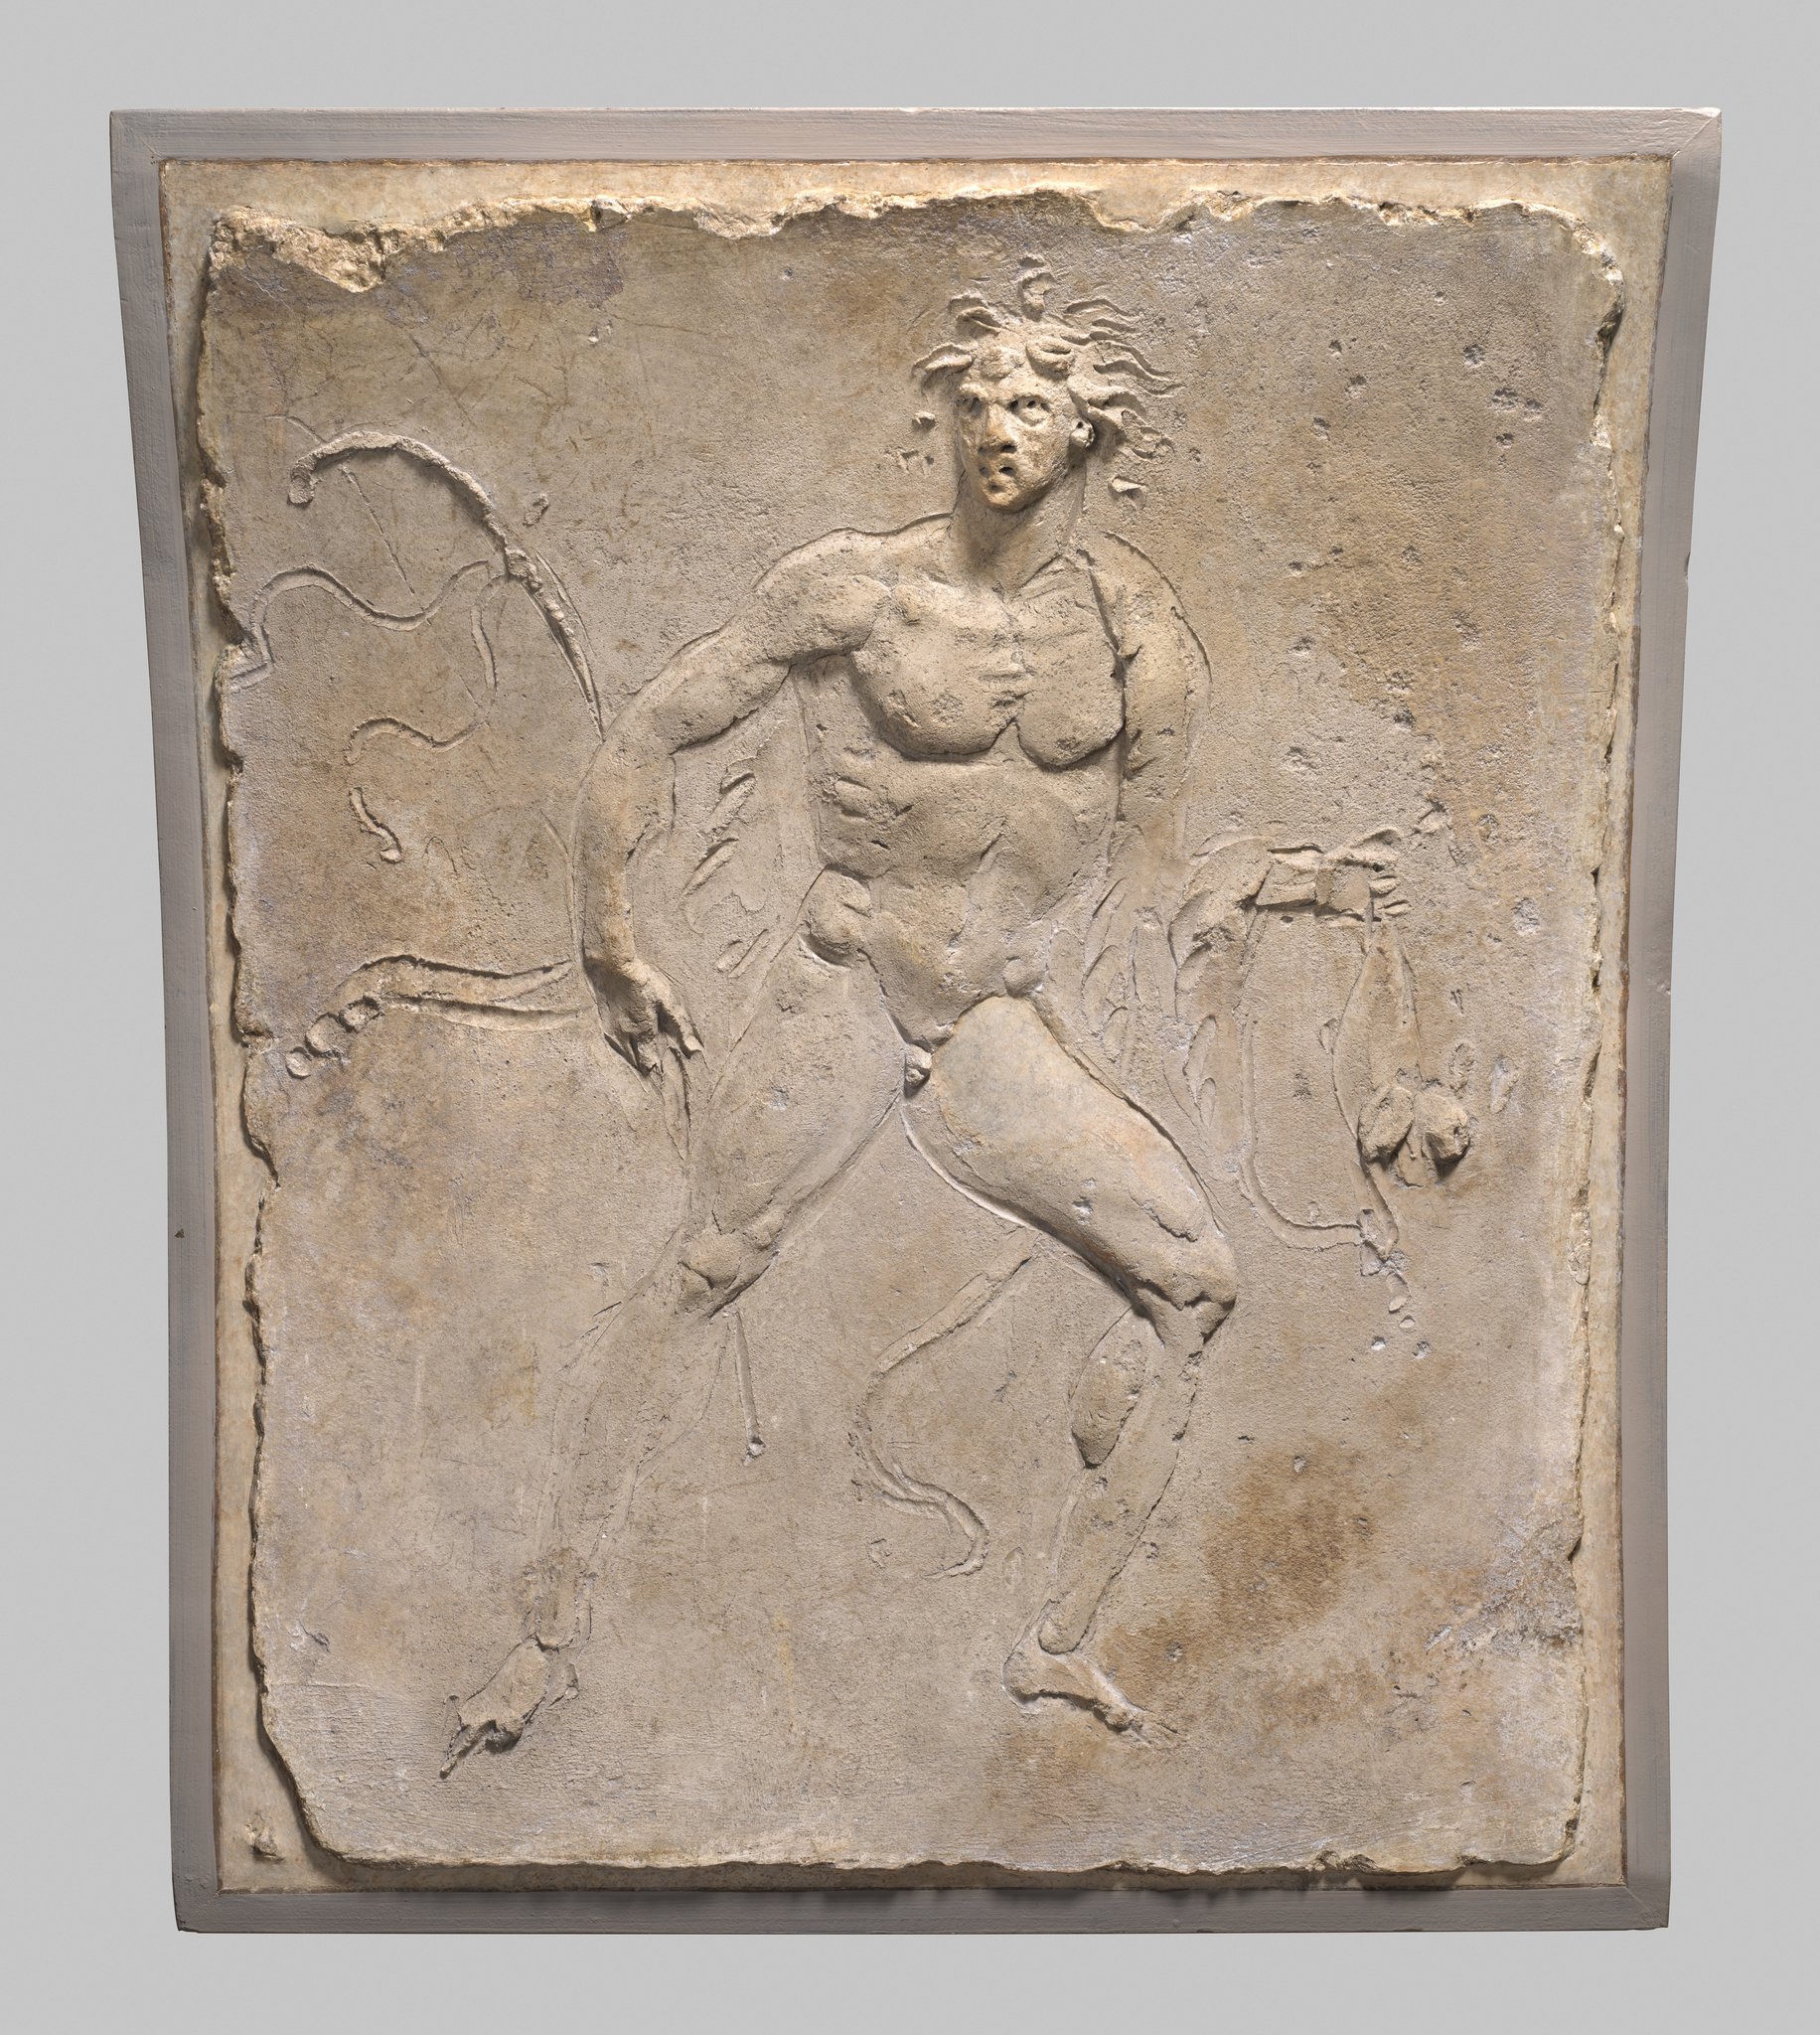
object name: stucco relief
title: Stucco relief panel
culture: roman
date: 51-100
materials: plaster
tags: male nudes